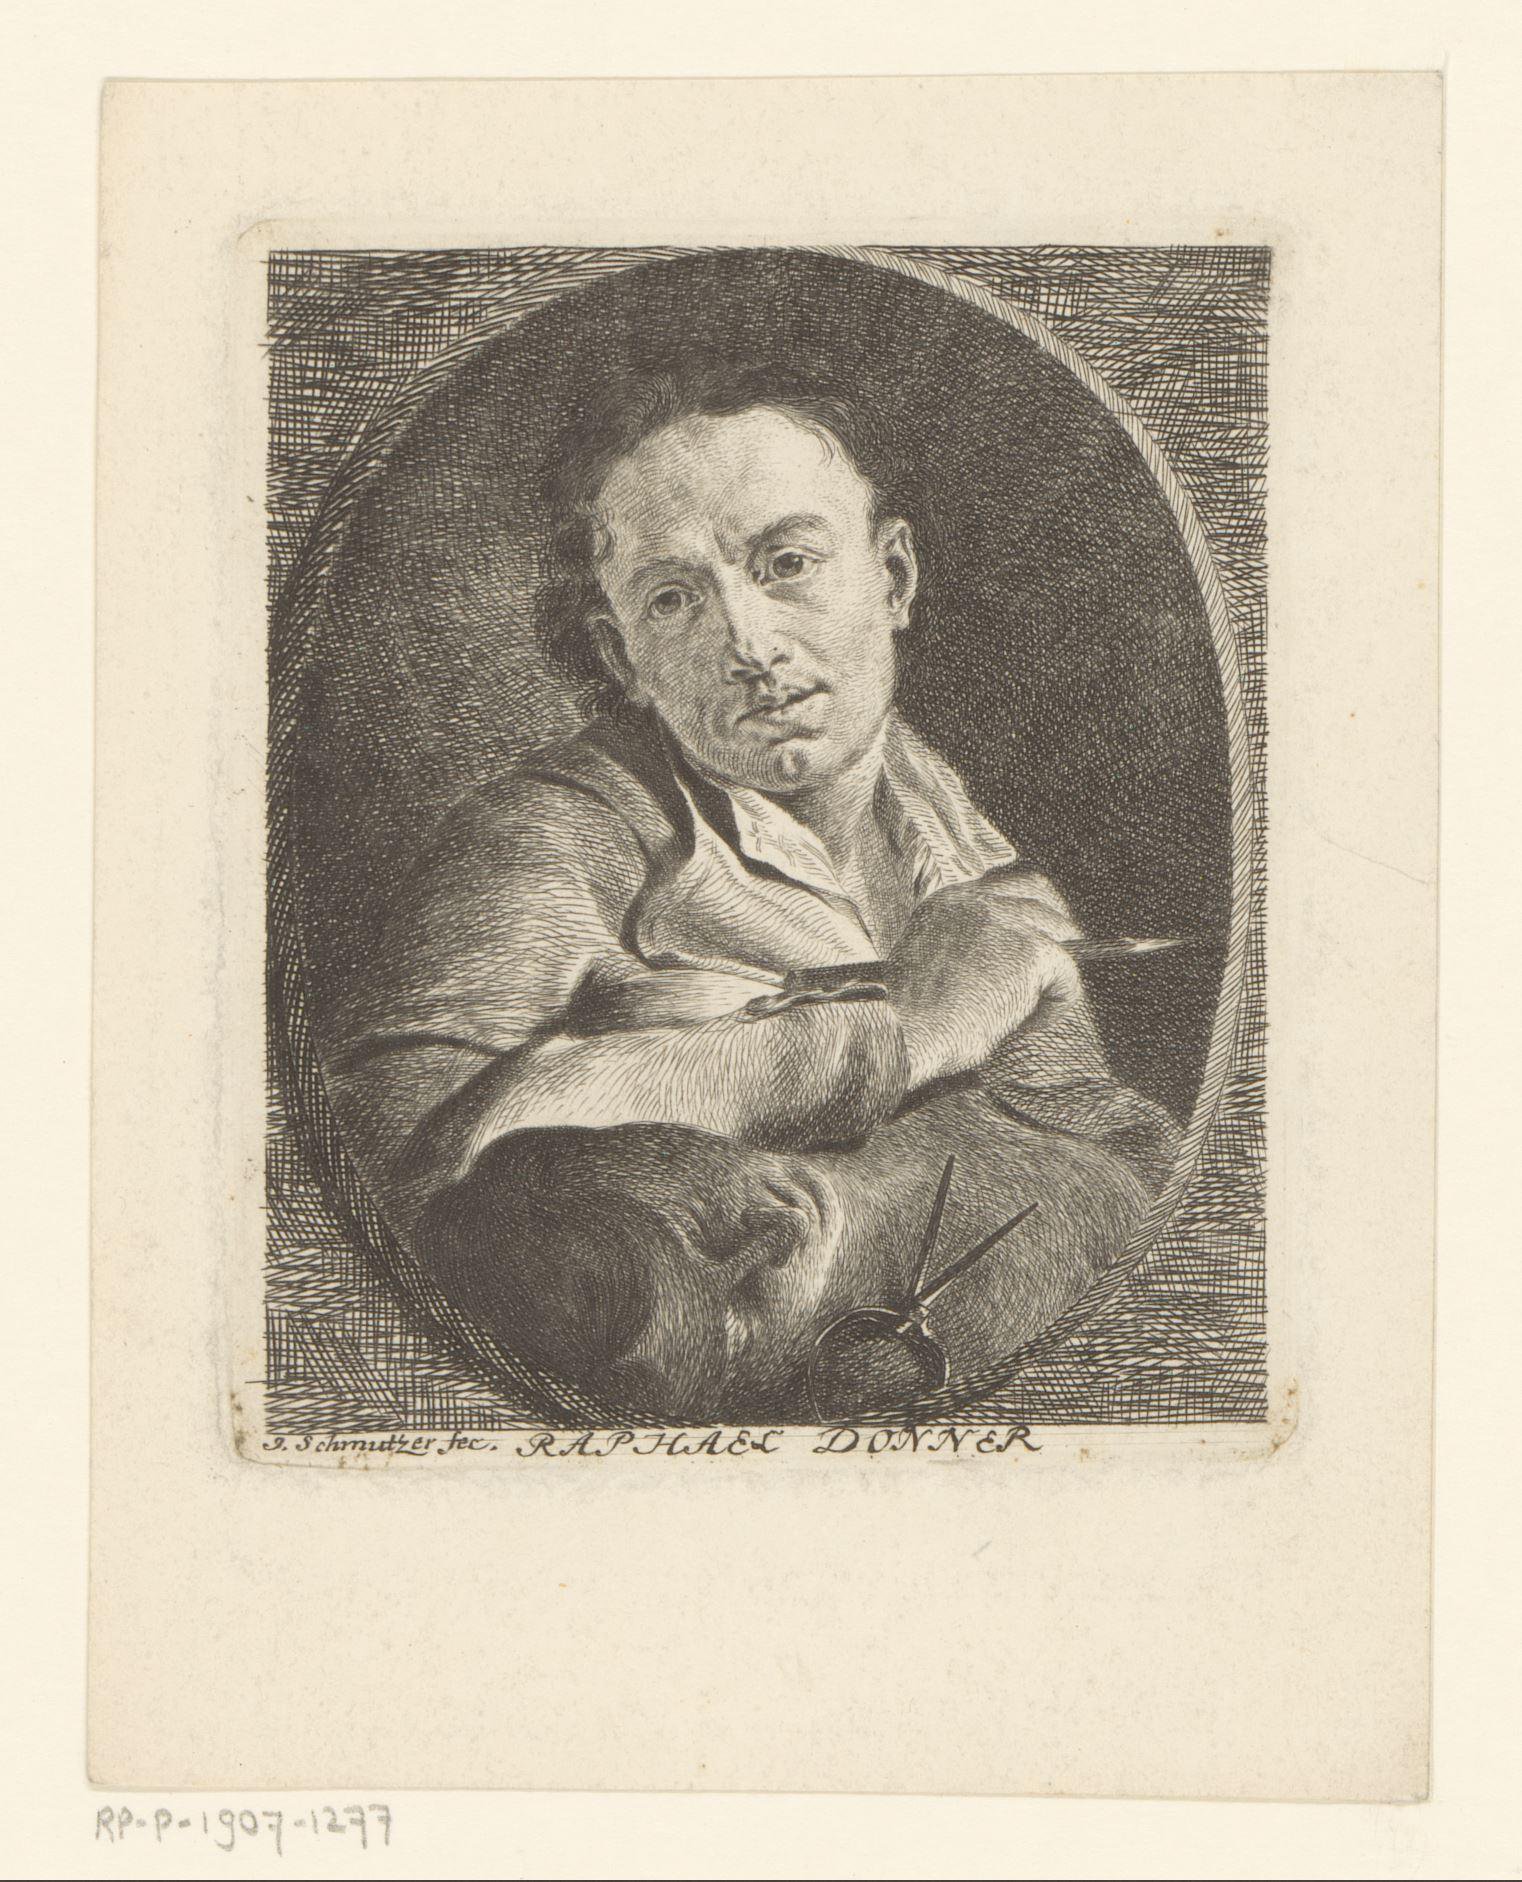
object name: print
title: Portret van George Raphael Johann Donner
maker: jakob matthias schmutzer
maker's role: print maker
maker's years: 1733-1811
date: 1743-1811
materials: paper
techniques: etching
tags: sculptor at work, historical persons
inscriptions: collector's mark: Lugt 2228